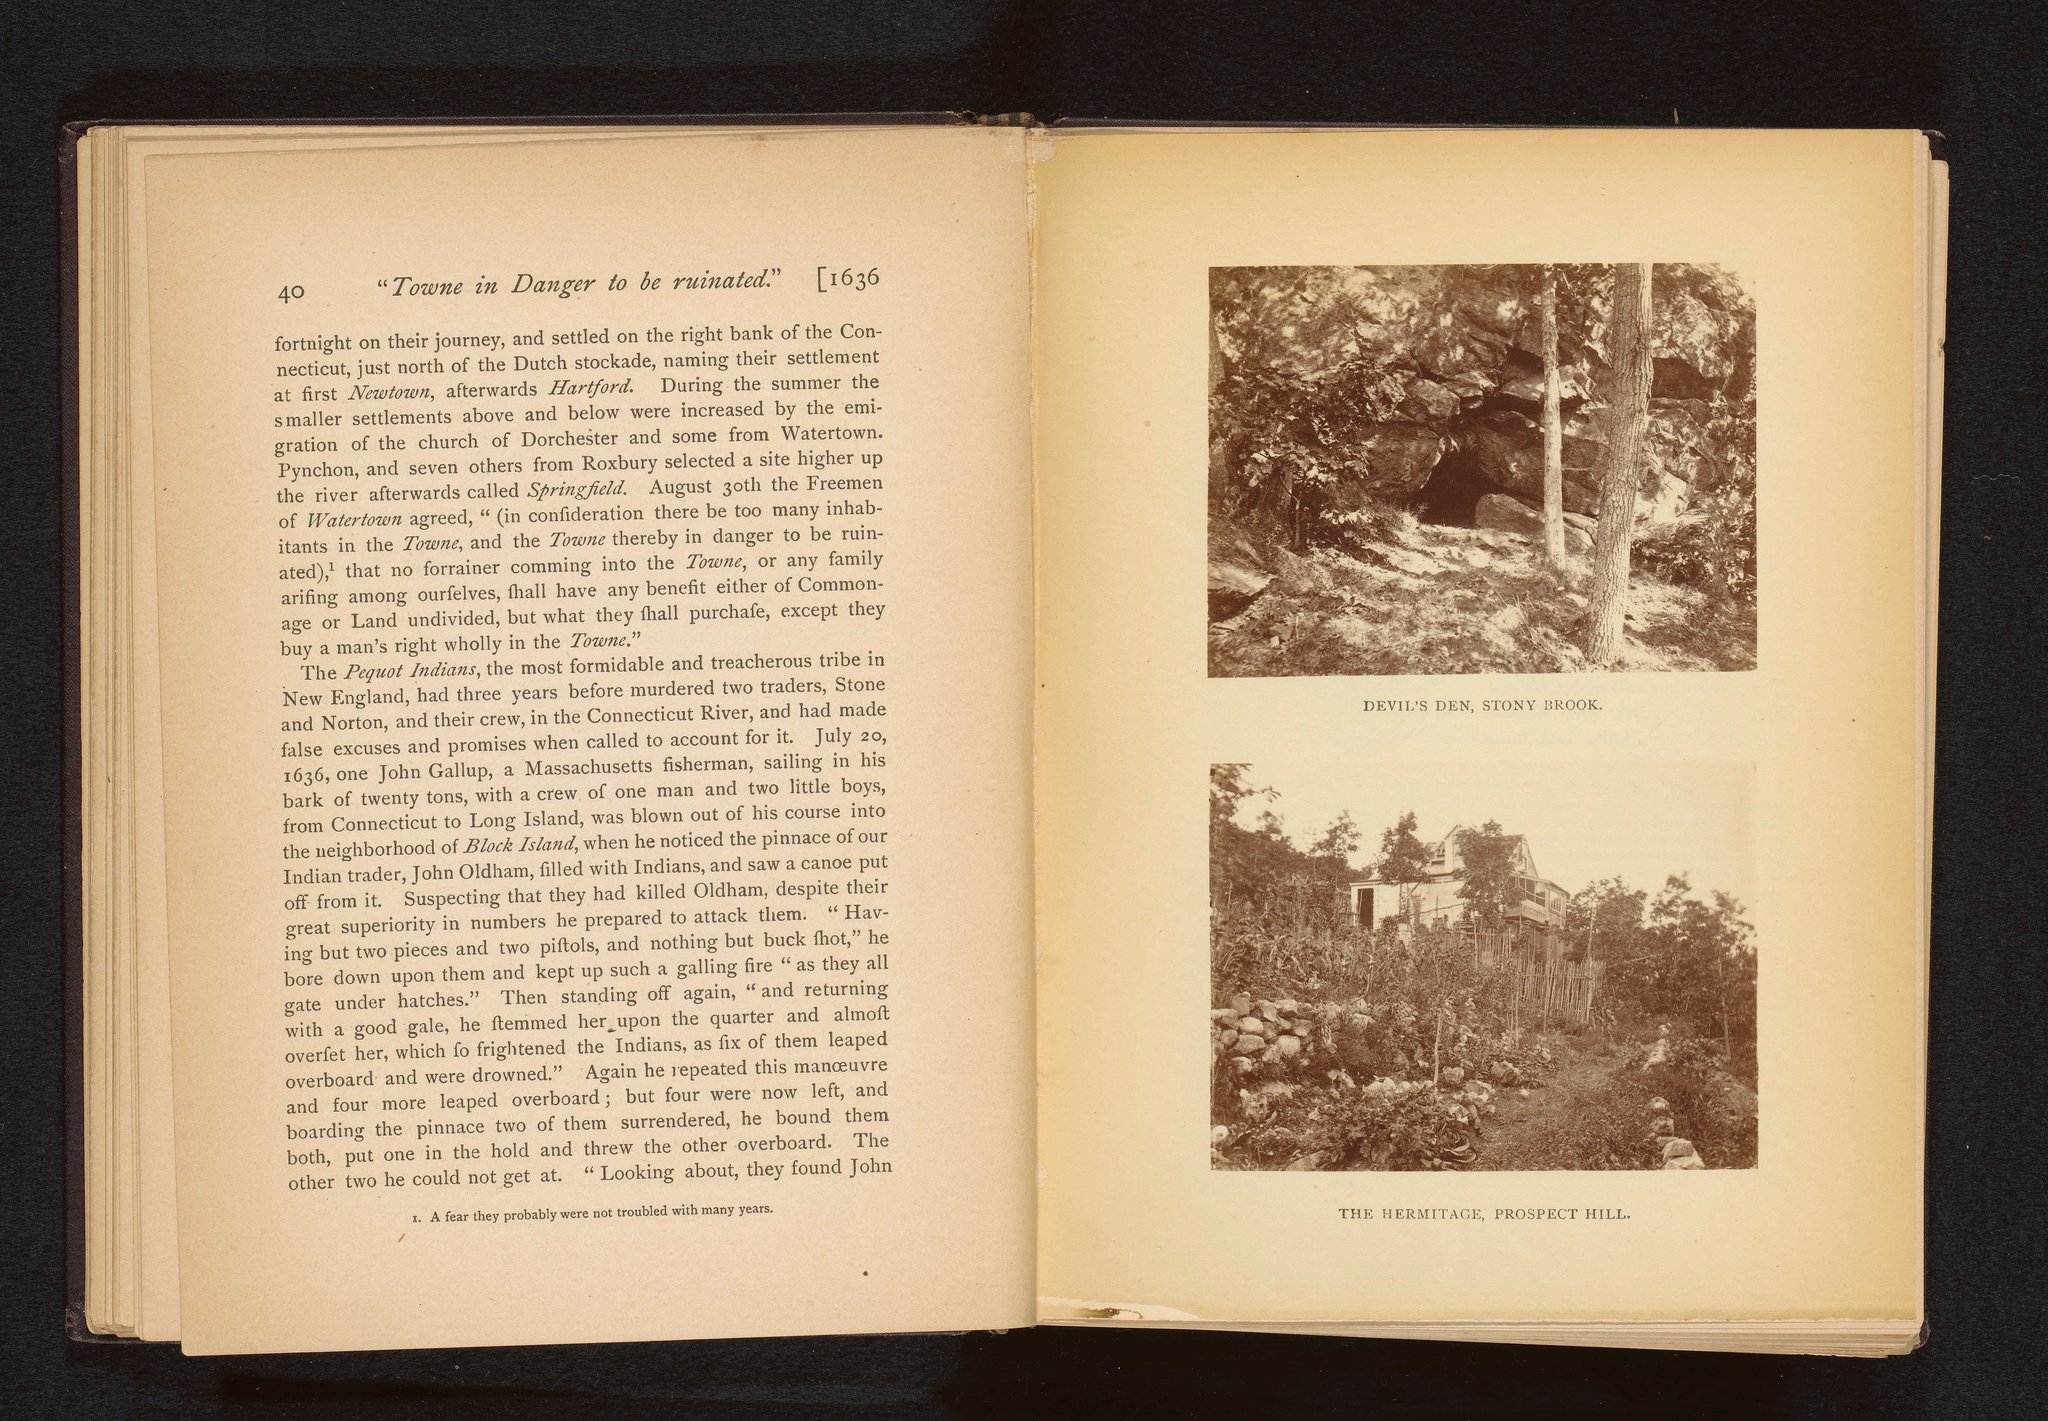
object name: photograph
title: Gezicht op een huis op Prospect Hill, Massachusetts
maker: thomas r. lewis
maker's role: publisher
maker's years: 1845-1901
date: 1874-1879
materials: photographic support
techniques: albumen print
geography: prospect hill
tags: (high) hill, housing